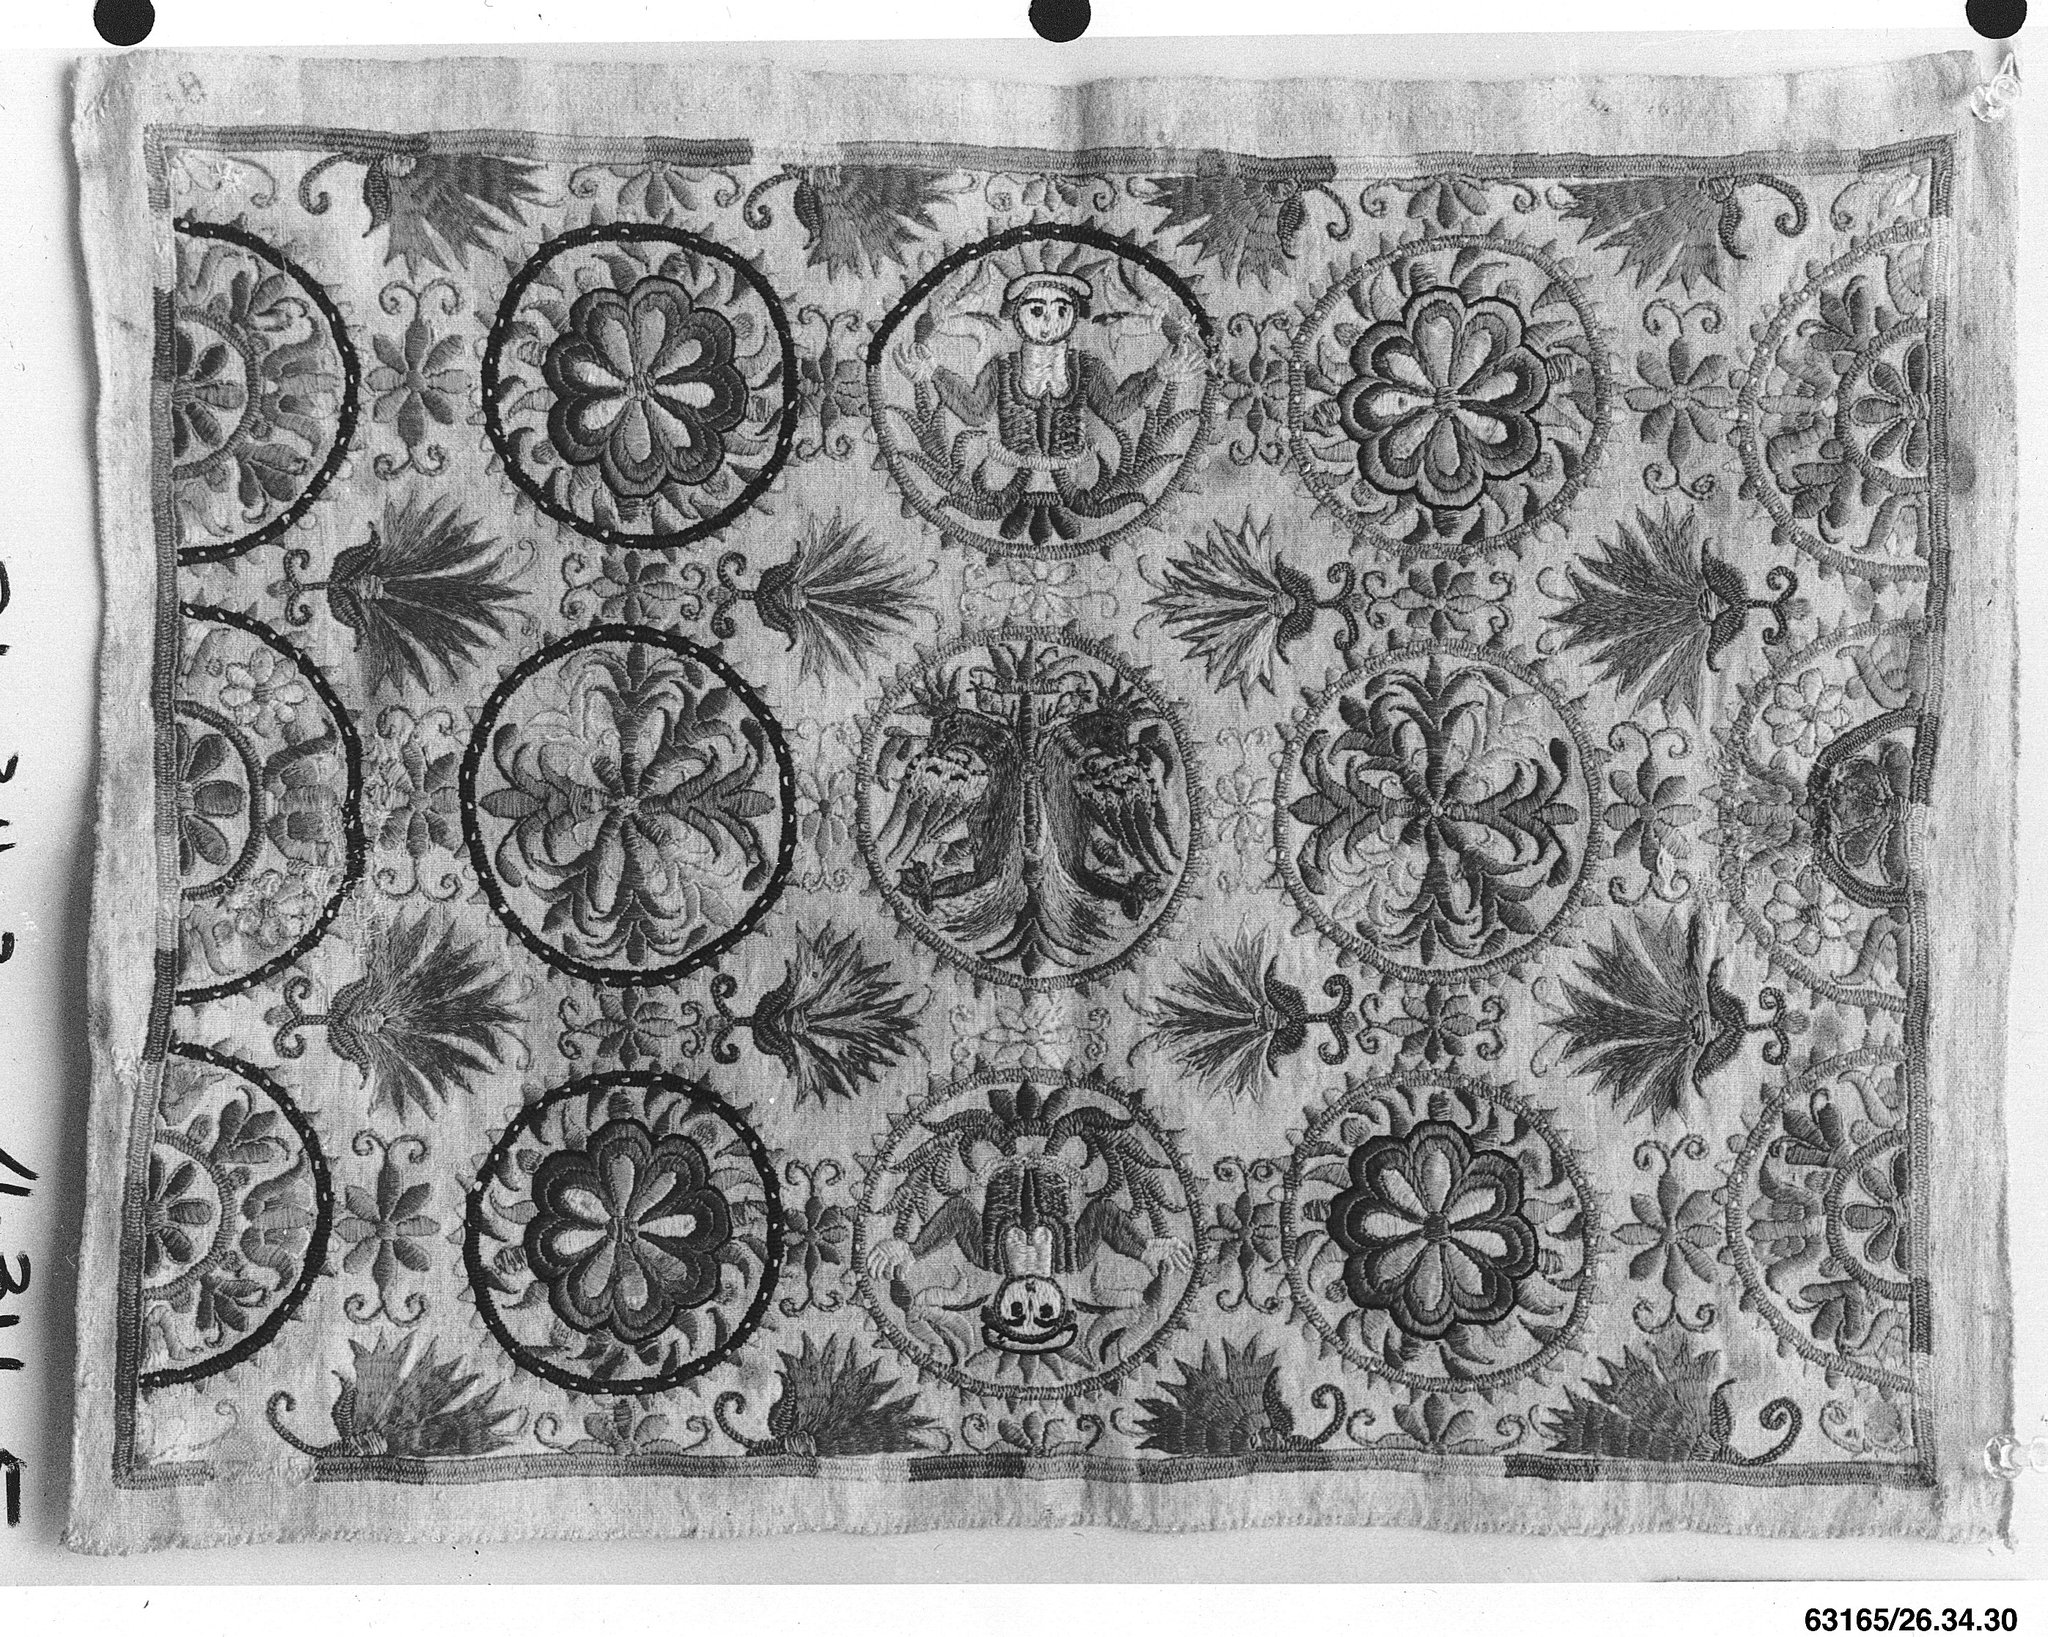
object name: square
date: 1701-1800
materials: linen, metal thread, silk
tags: human figures,flowers,leaves